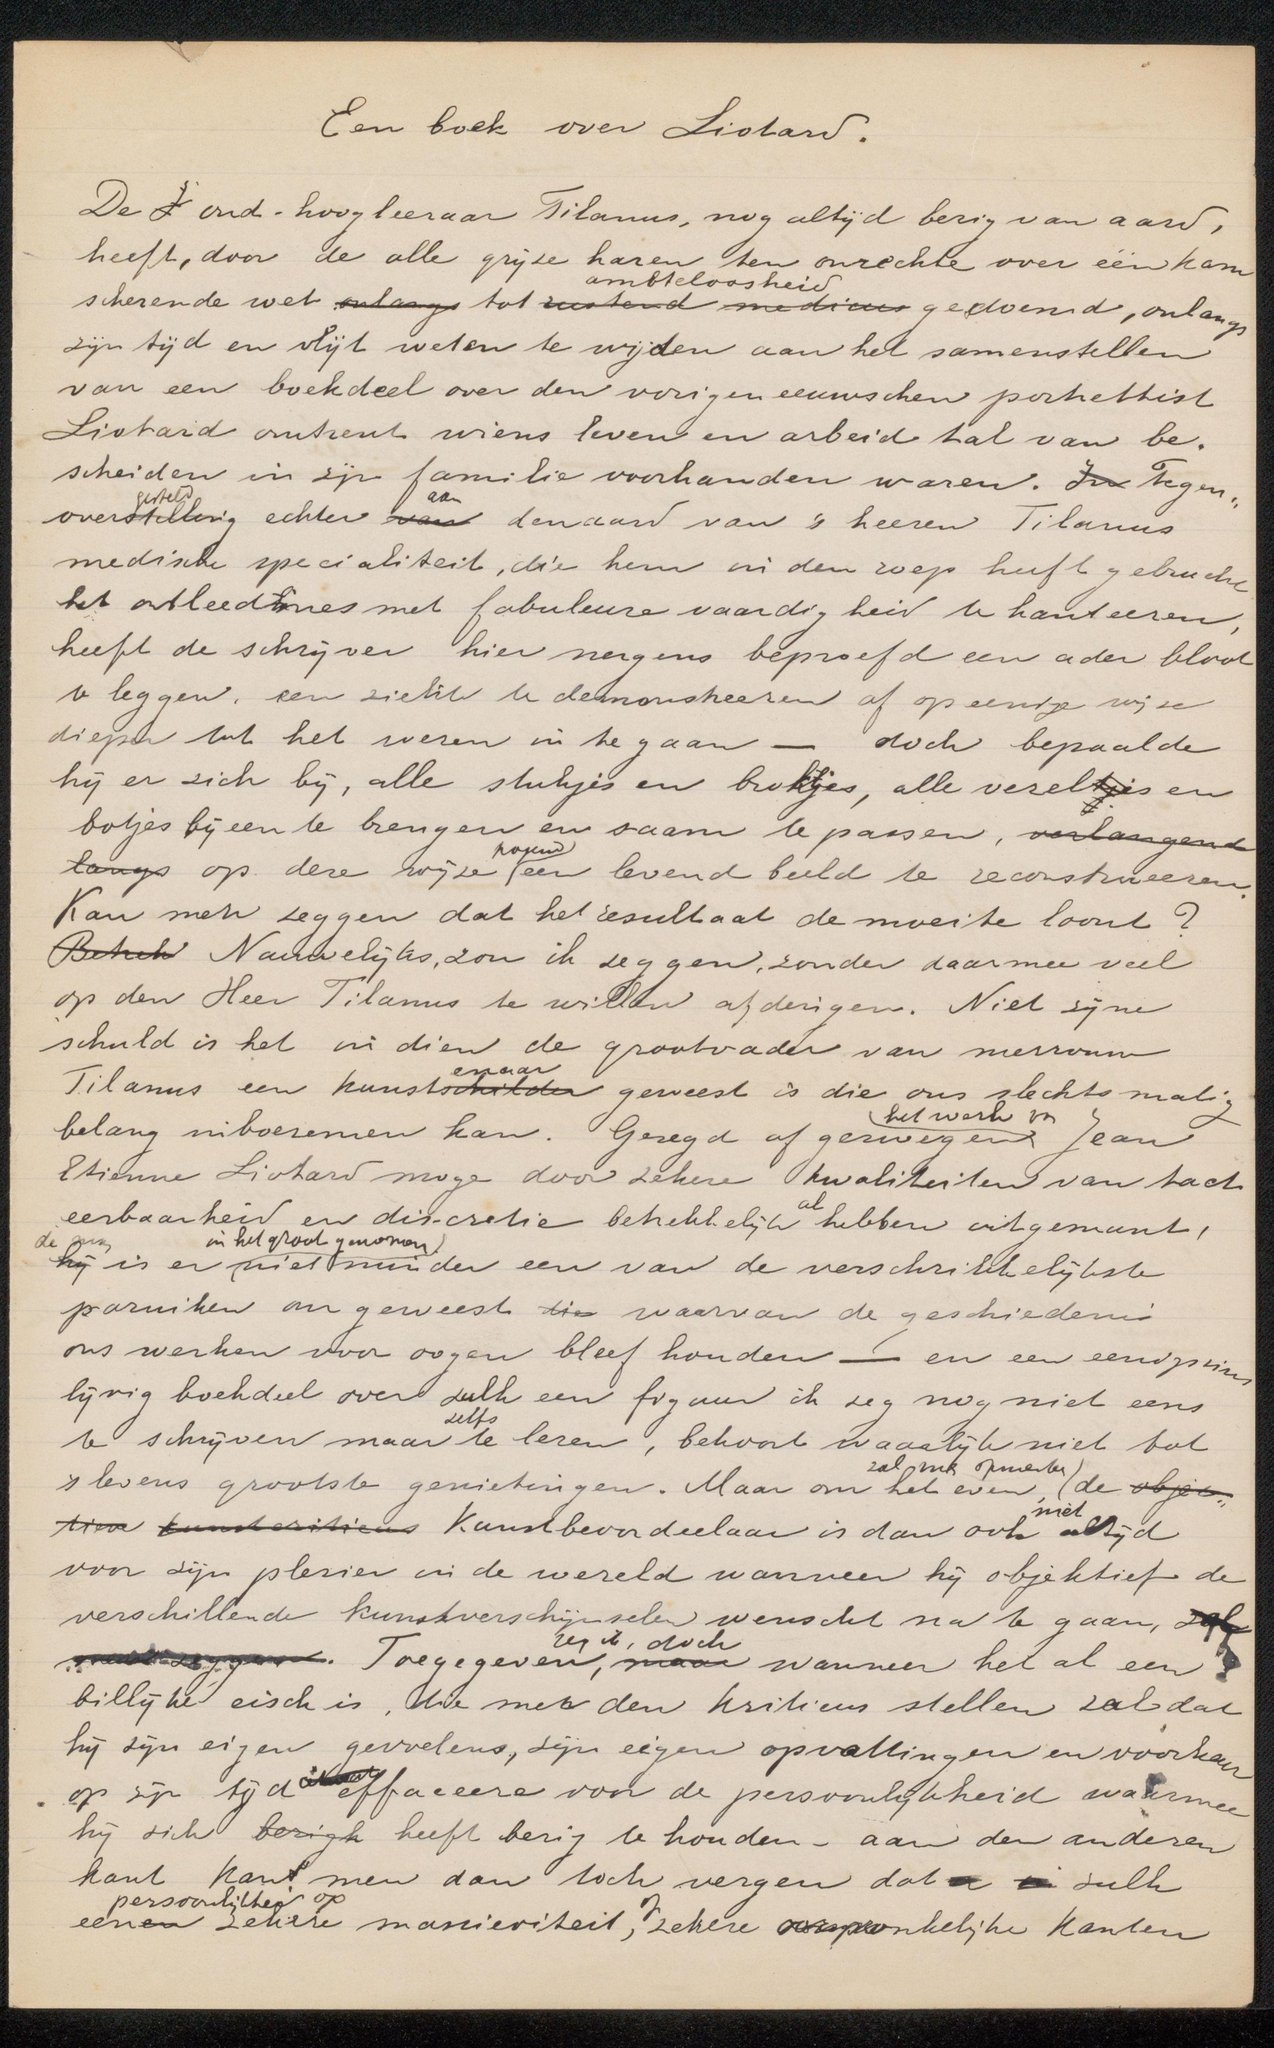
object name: manuscript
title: Handschrift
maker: jan veth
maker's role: designer, draughtsman, painter, print maker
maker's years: 1864-1925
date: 1897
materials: ink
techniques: pen, writing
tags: painter, print maker, jean-etienne liotard, arnhem, amsterdam, jan willem reinier tilanus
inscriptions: collector's mark: ‘RPK’